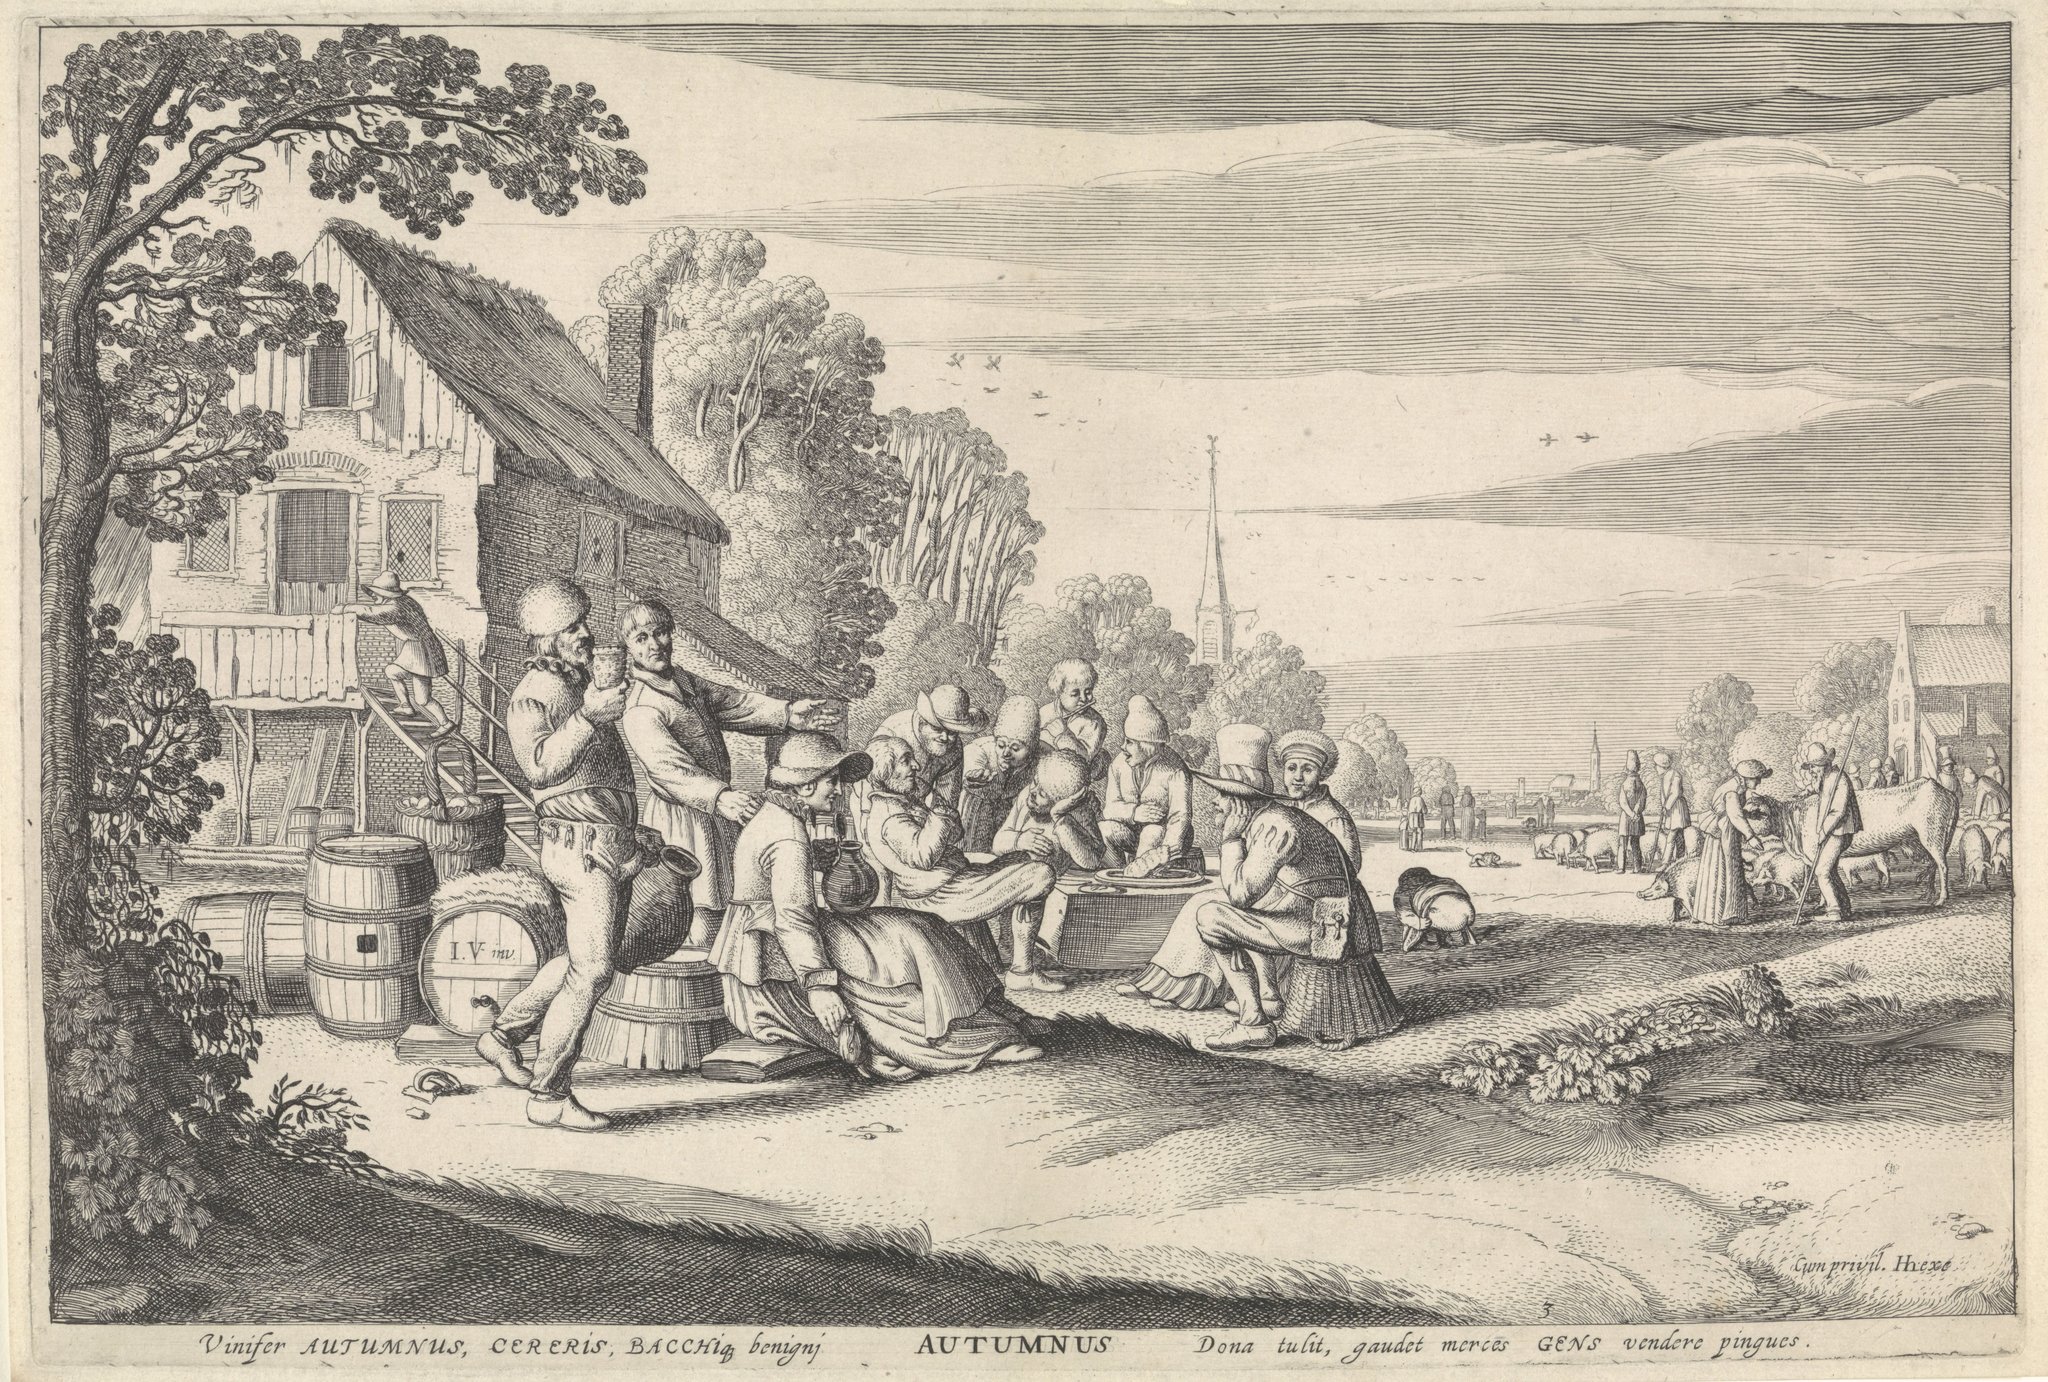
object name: print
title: De vier seizoenen A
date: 1617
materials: paper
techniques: engraving, etching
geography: northern netherlands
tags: autumn, fall, 'autumnus'; 'autunno' (ripa), autumn landscape; landscape symbolizing autumn (the four seasons of the year) (+ with scenes showing human occupations ~ seasons and months)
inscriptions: collector's mark: Lugt 240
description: Drinkende, etende en converserende figuren bij een huis en rechts figuren met vee. Verbeelding van het jaargetijde herfst, derde prent van een serie van vier.